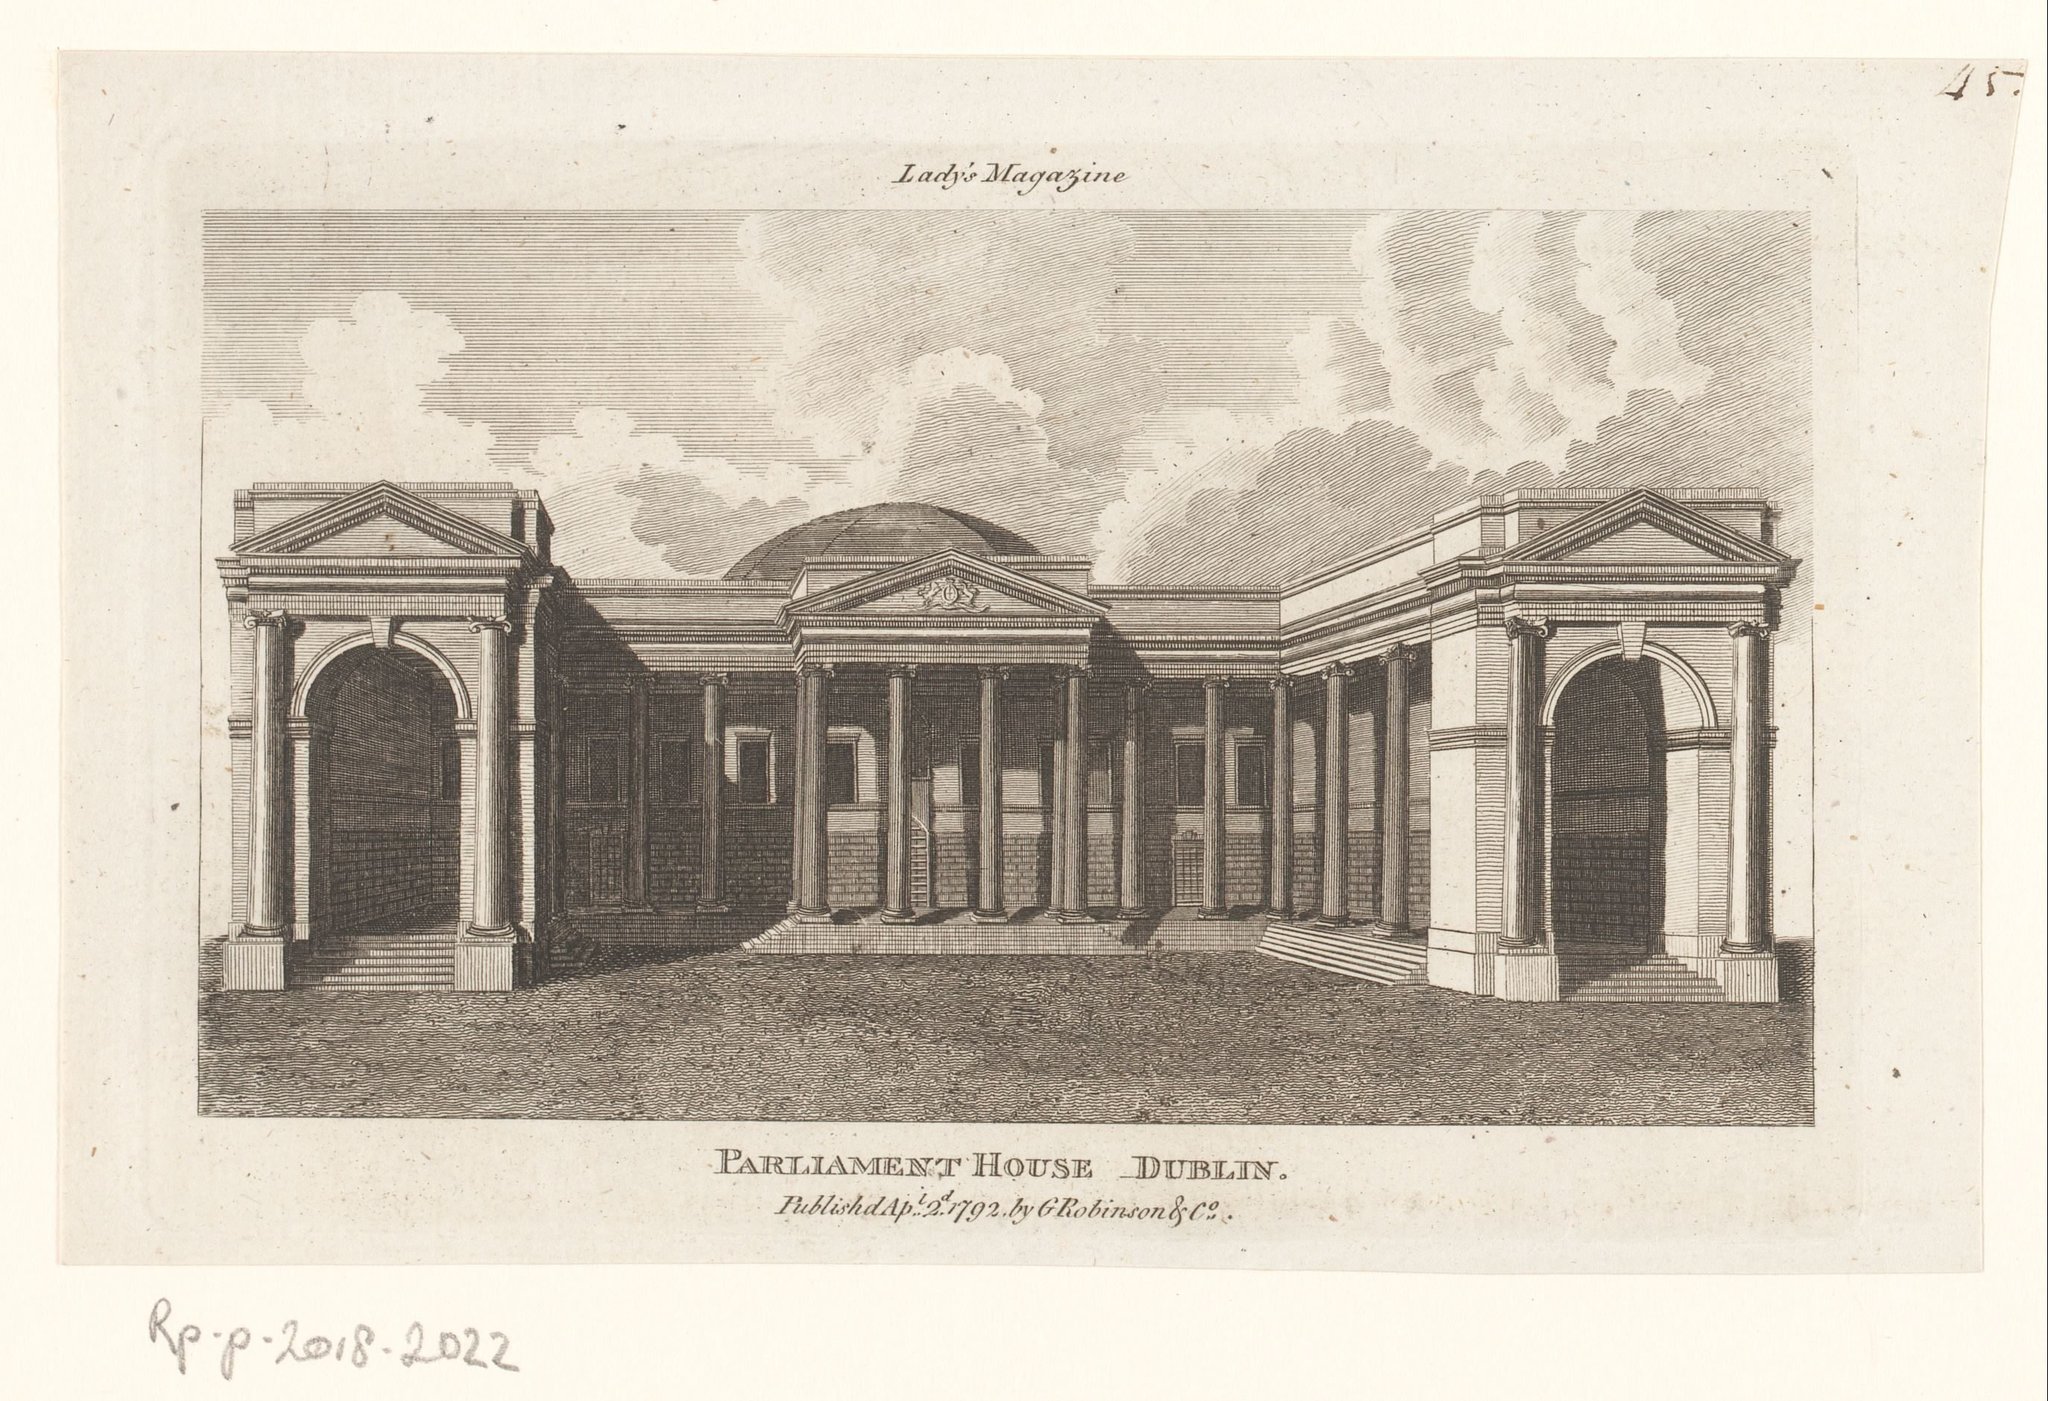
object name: print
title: Parliament House Dublin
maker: Anonymous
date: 1792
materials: paper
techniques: etching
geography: london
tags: lower house, parliament, chamber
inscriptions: collector's mark: Lugt 2228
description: Prent gebruikt in: The Ladies Magazine or entertaining companion for the fair sex (...). Londen: G.G.J & J. Robinson, 1792.